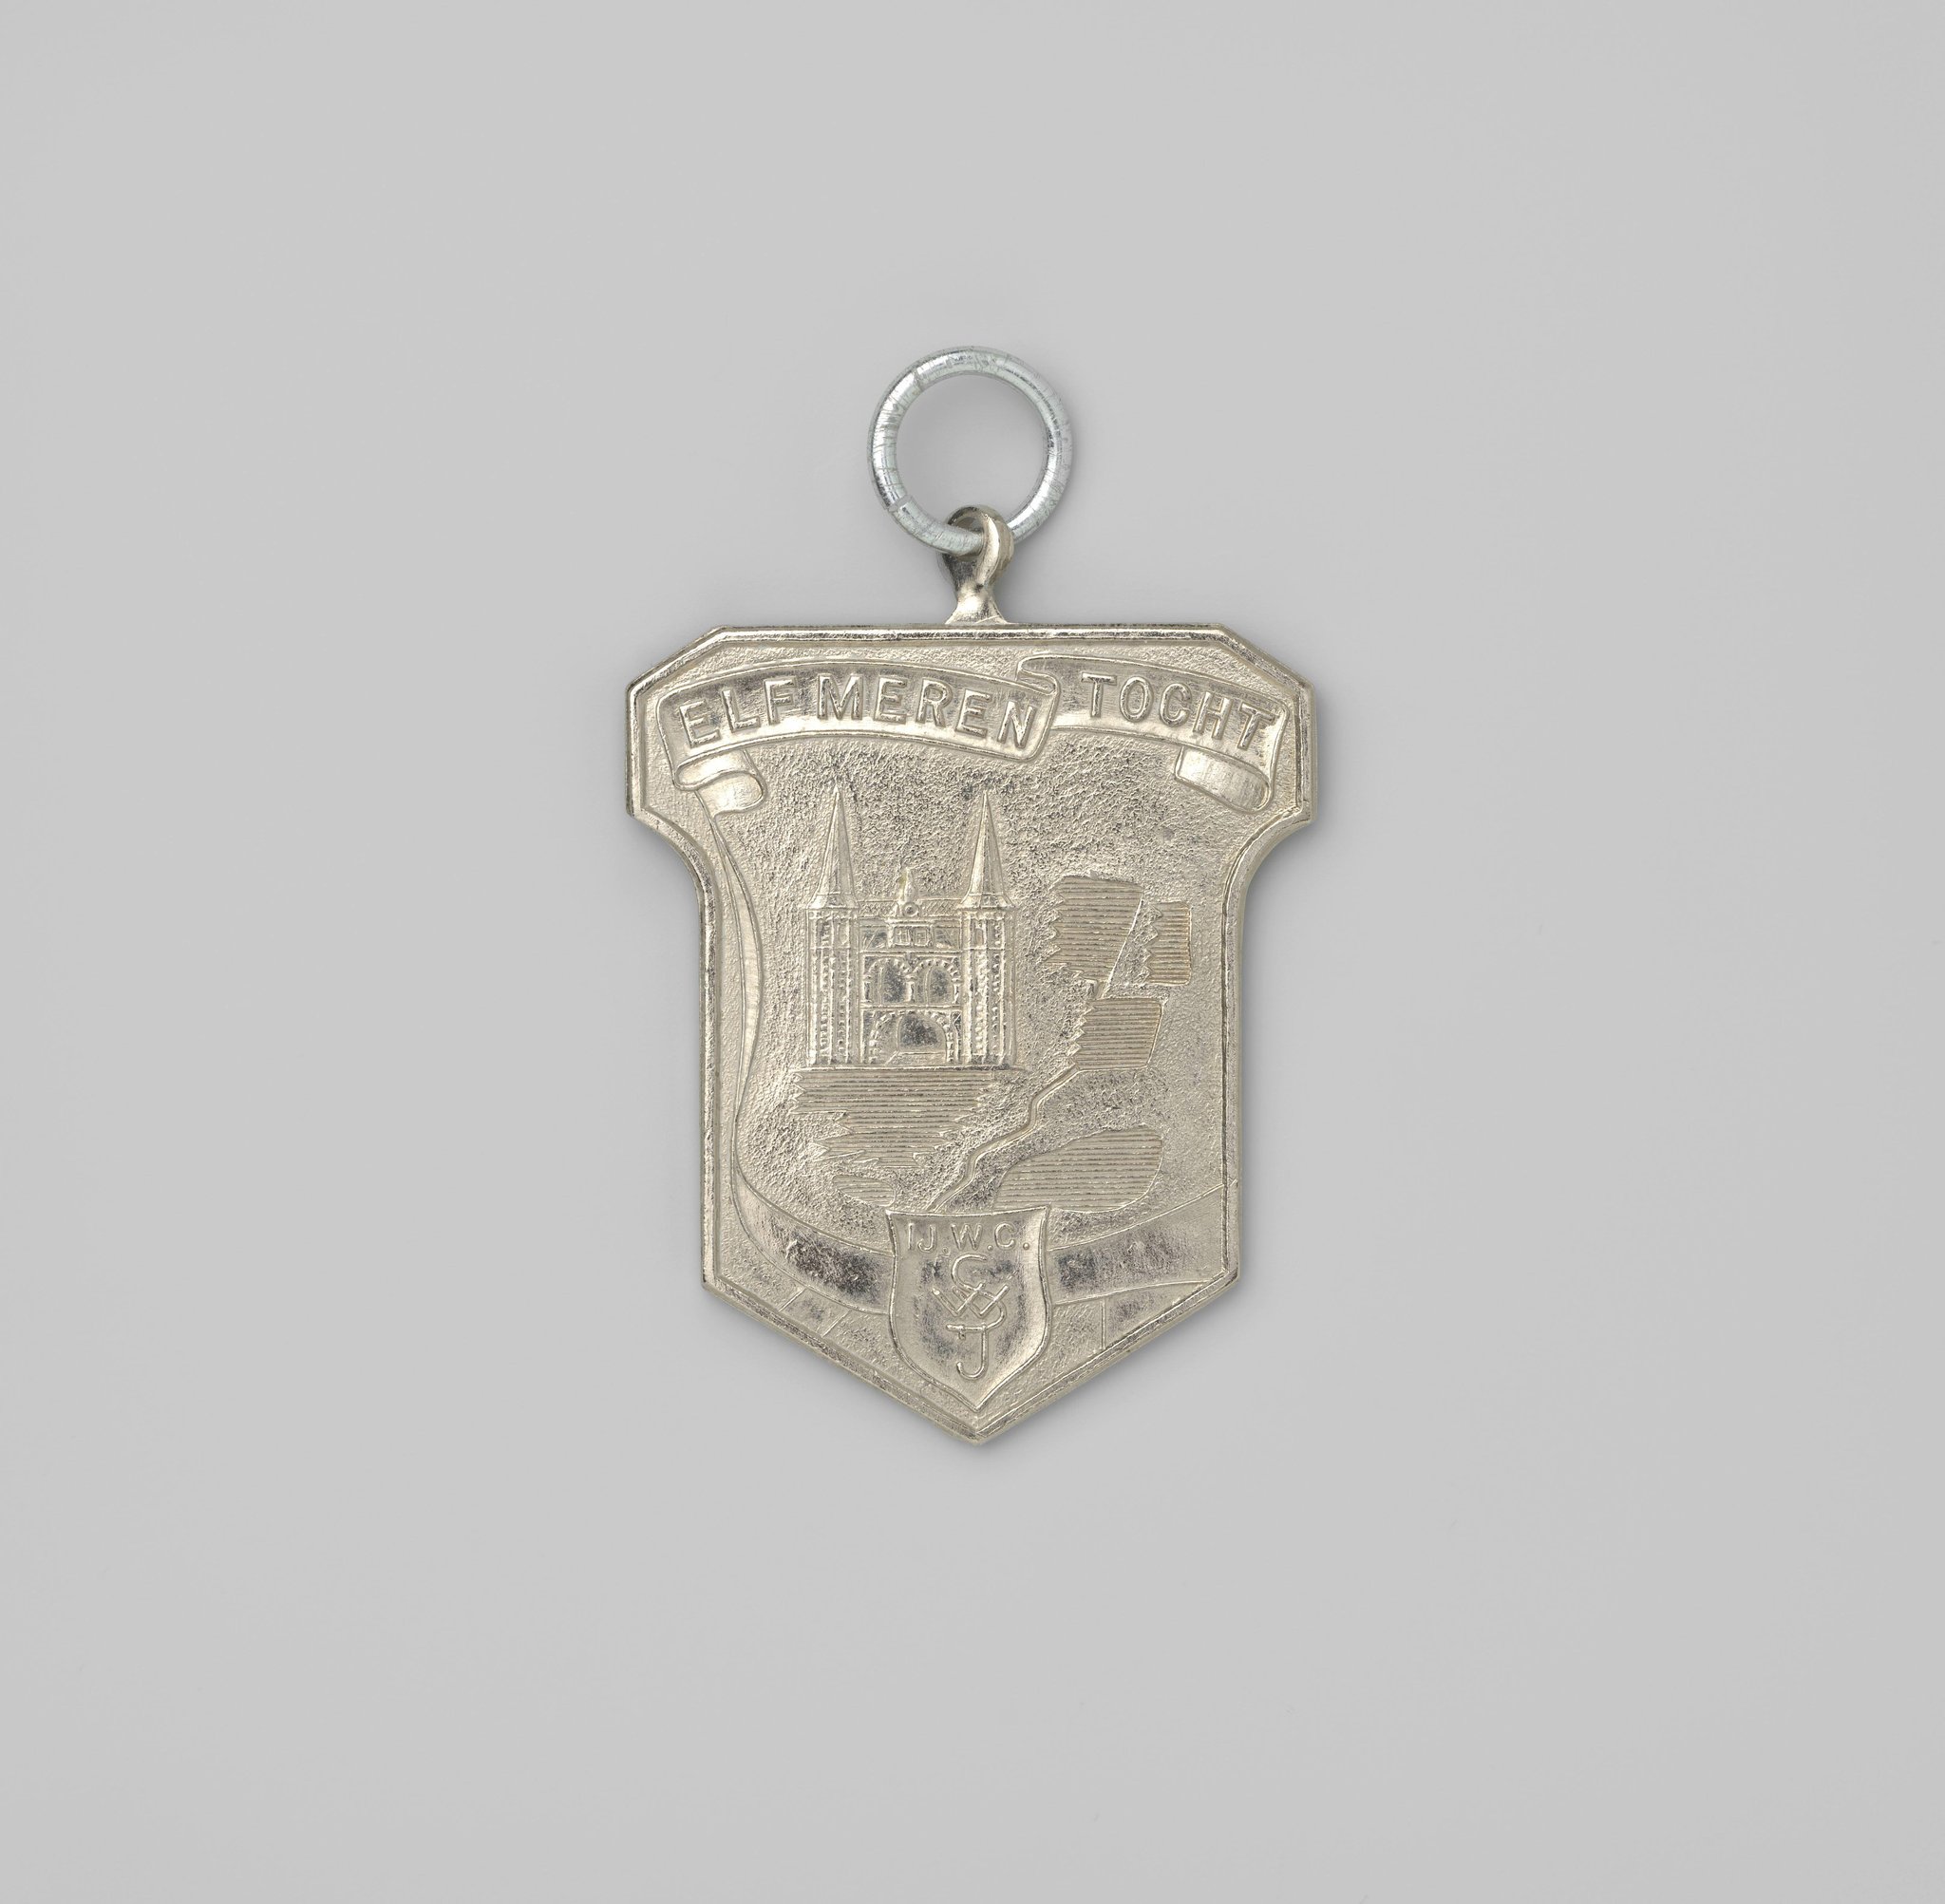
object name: onderscheidingsteken, onderscheiding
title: Onderscheiding Elf Meren Tocht 1987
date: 1987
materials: metal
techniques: striking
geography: sneek